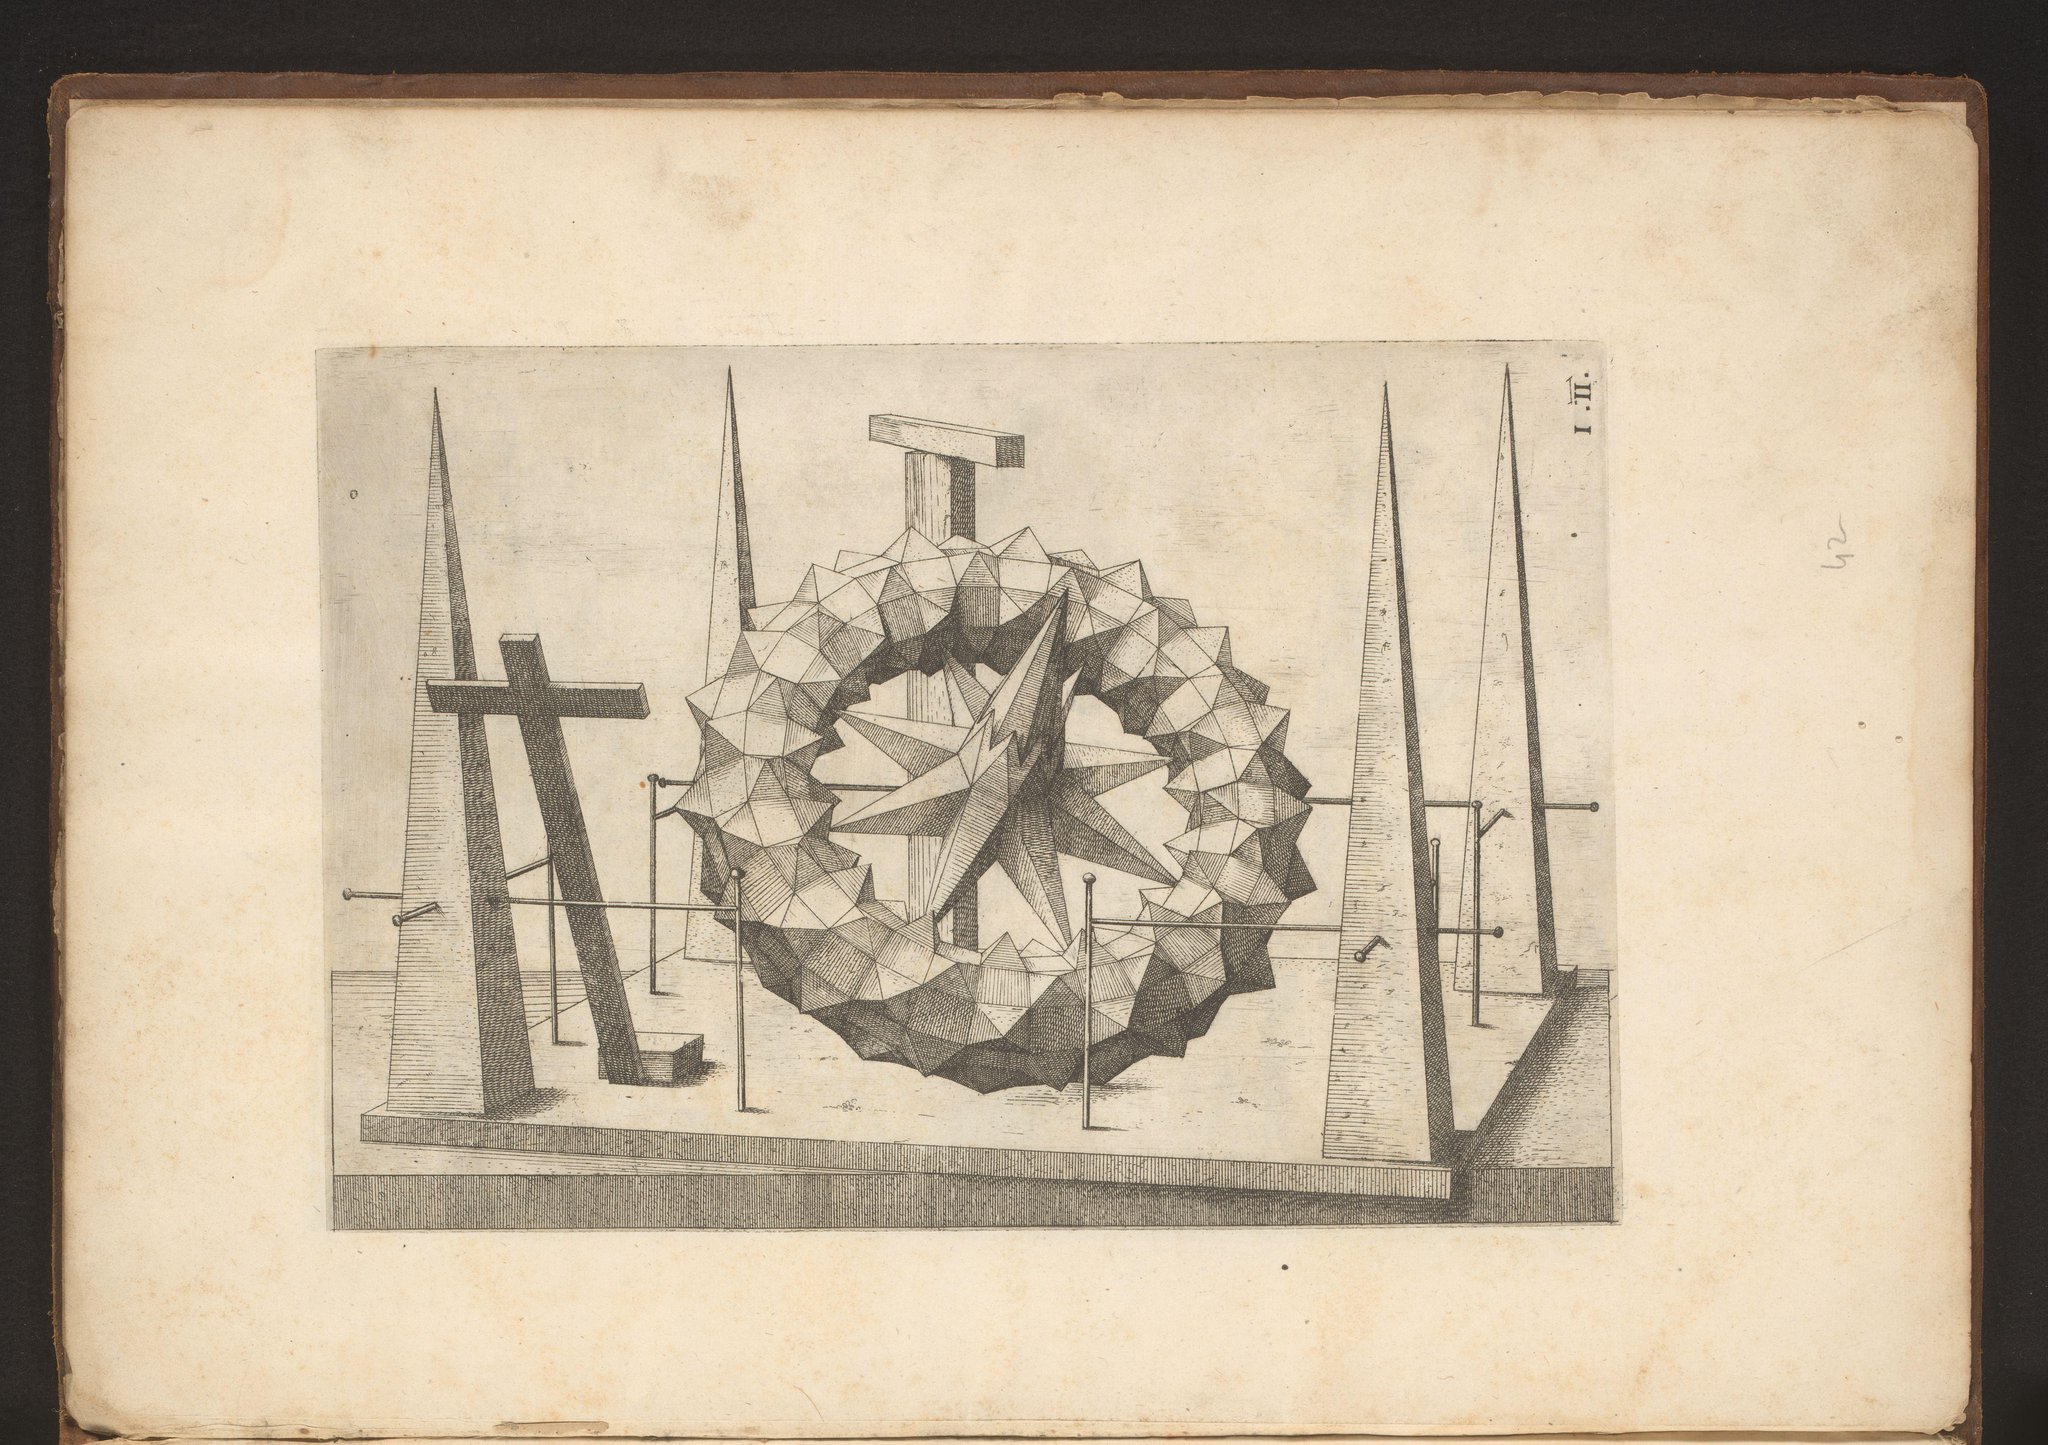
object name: print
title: Veelvlak met een torus als uitgangspunt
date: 1568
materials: paper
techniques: etching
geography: nuremberg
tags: quadrangular pyramid, other polyhedrons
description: Complex geometrische figuren (polyhedra) weergegeven in een opstelling met vier piramides in de hoeken, centraal een stervormige veelvlak . Genummerd: J.II. Deze prent maakt deel uit van een boek.